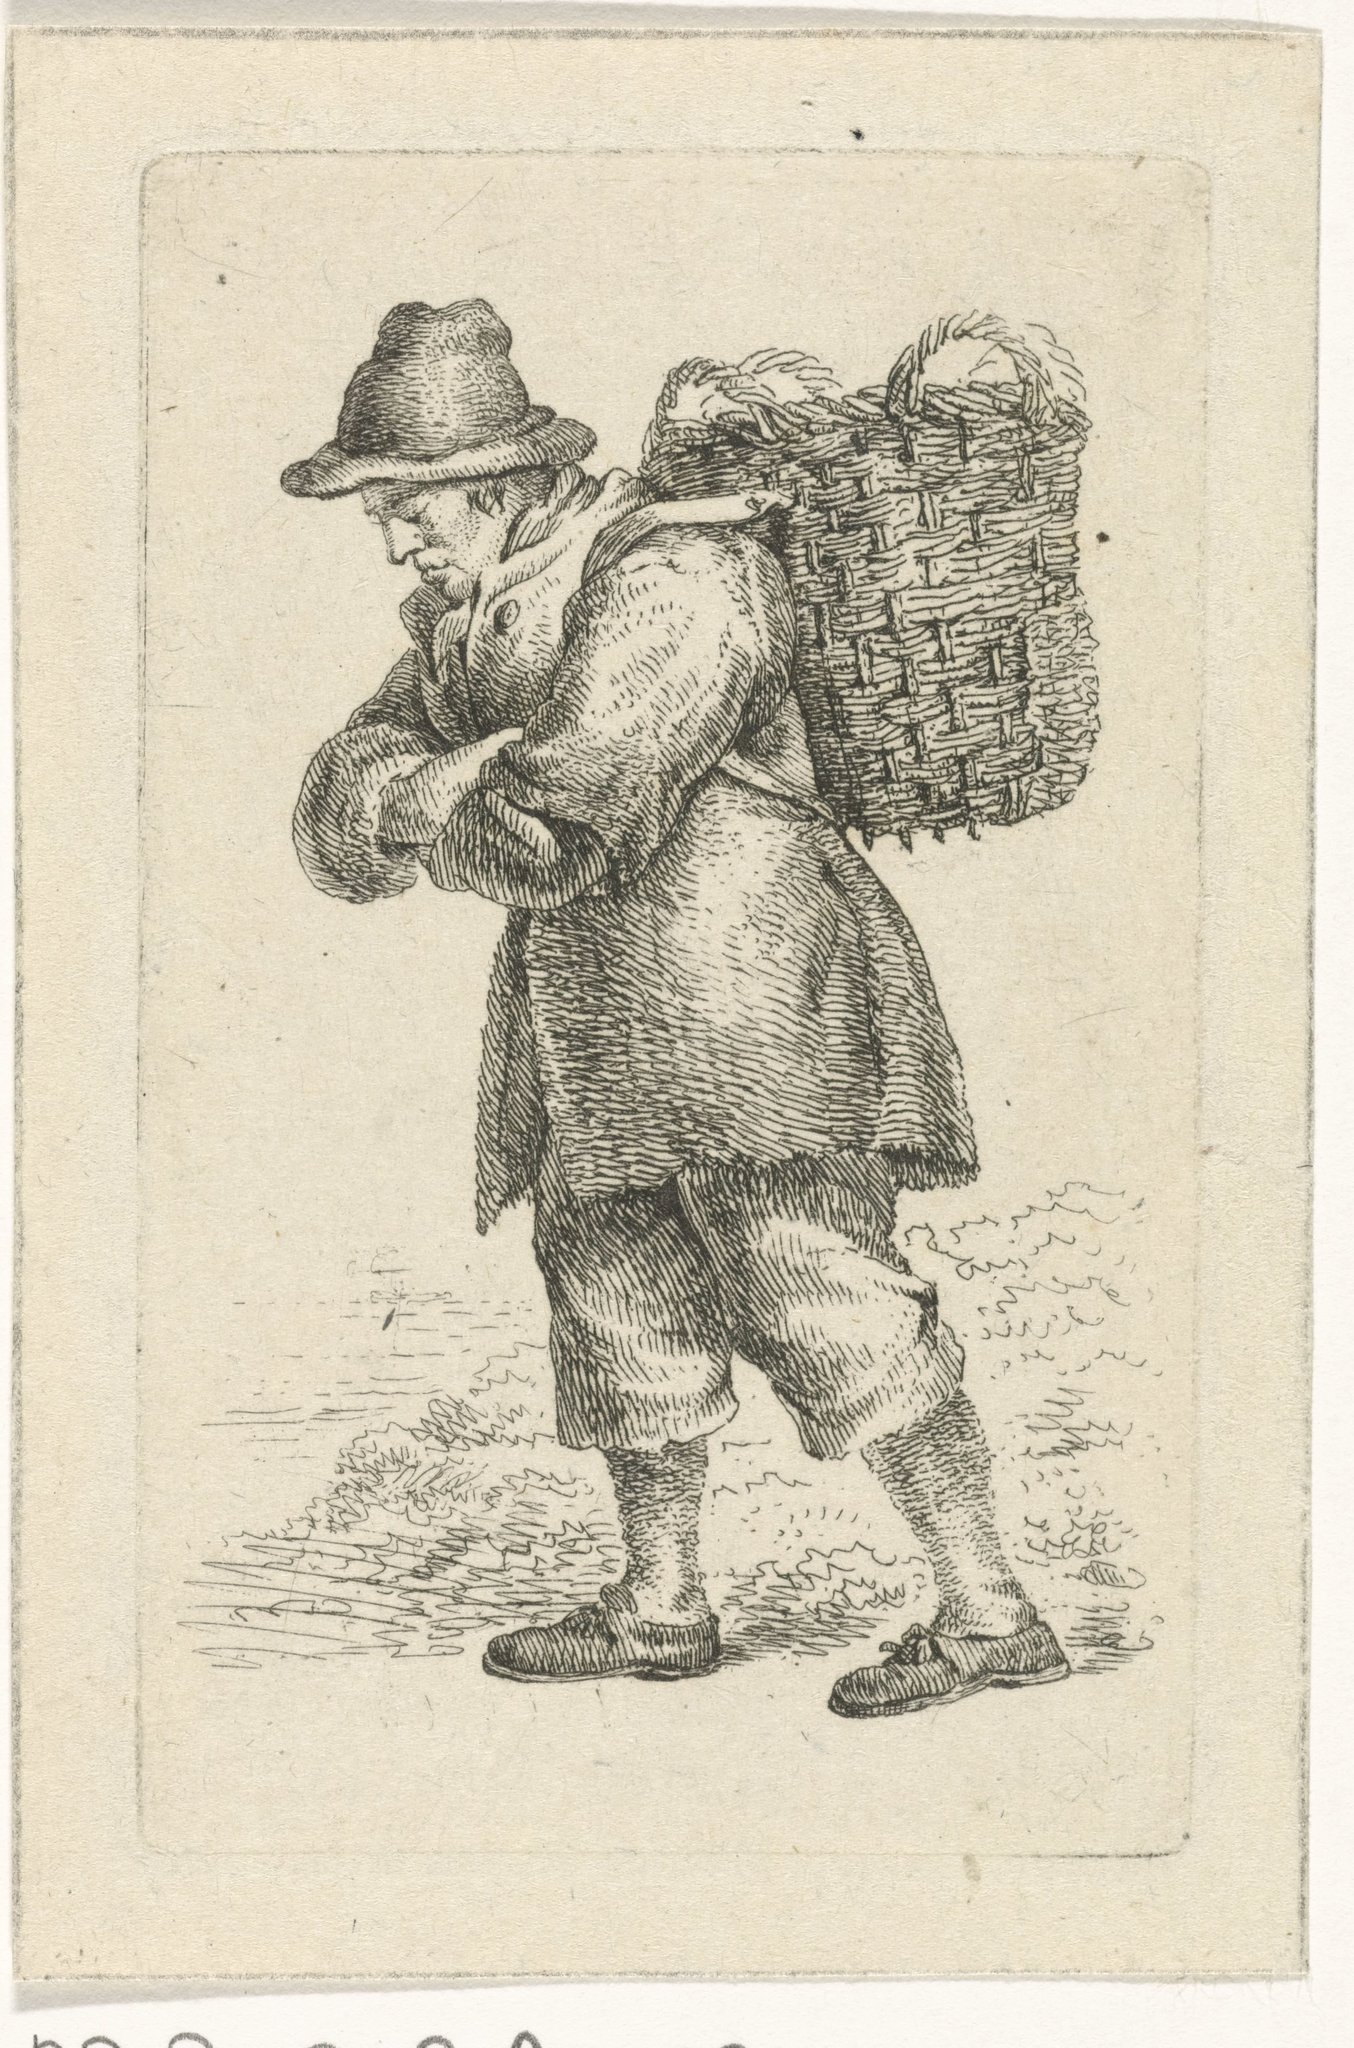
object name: print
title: Visboer, met mand op de rug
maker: françois joseph pfeiffer (ii)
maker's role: draughtsman, print maker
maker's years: 1778-1835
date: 1793-1835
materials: paper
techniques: etching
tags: standing figure, carrying something in basket, bag, rucksack, etc.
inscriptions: collector's mark: Lugt 2228